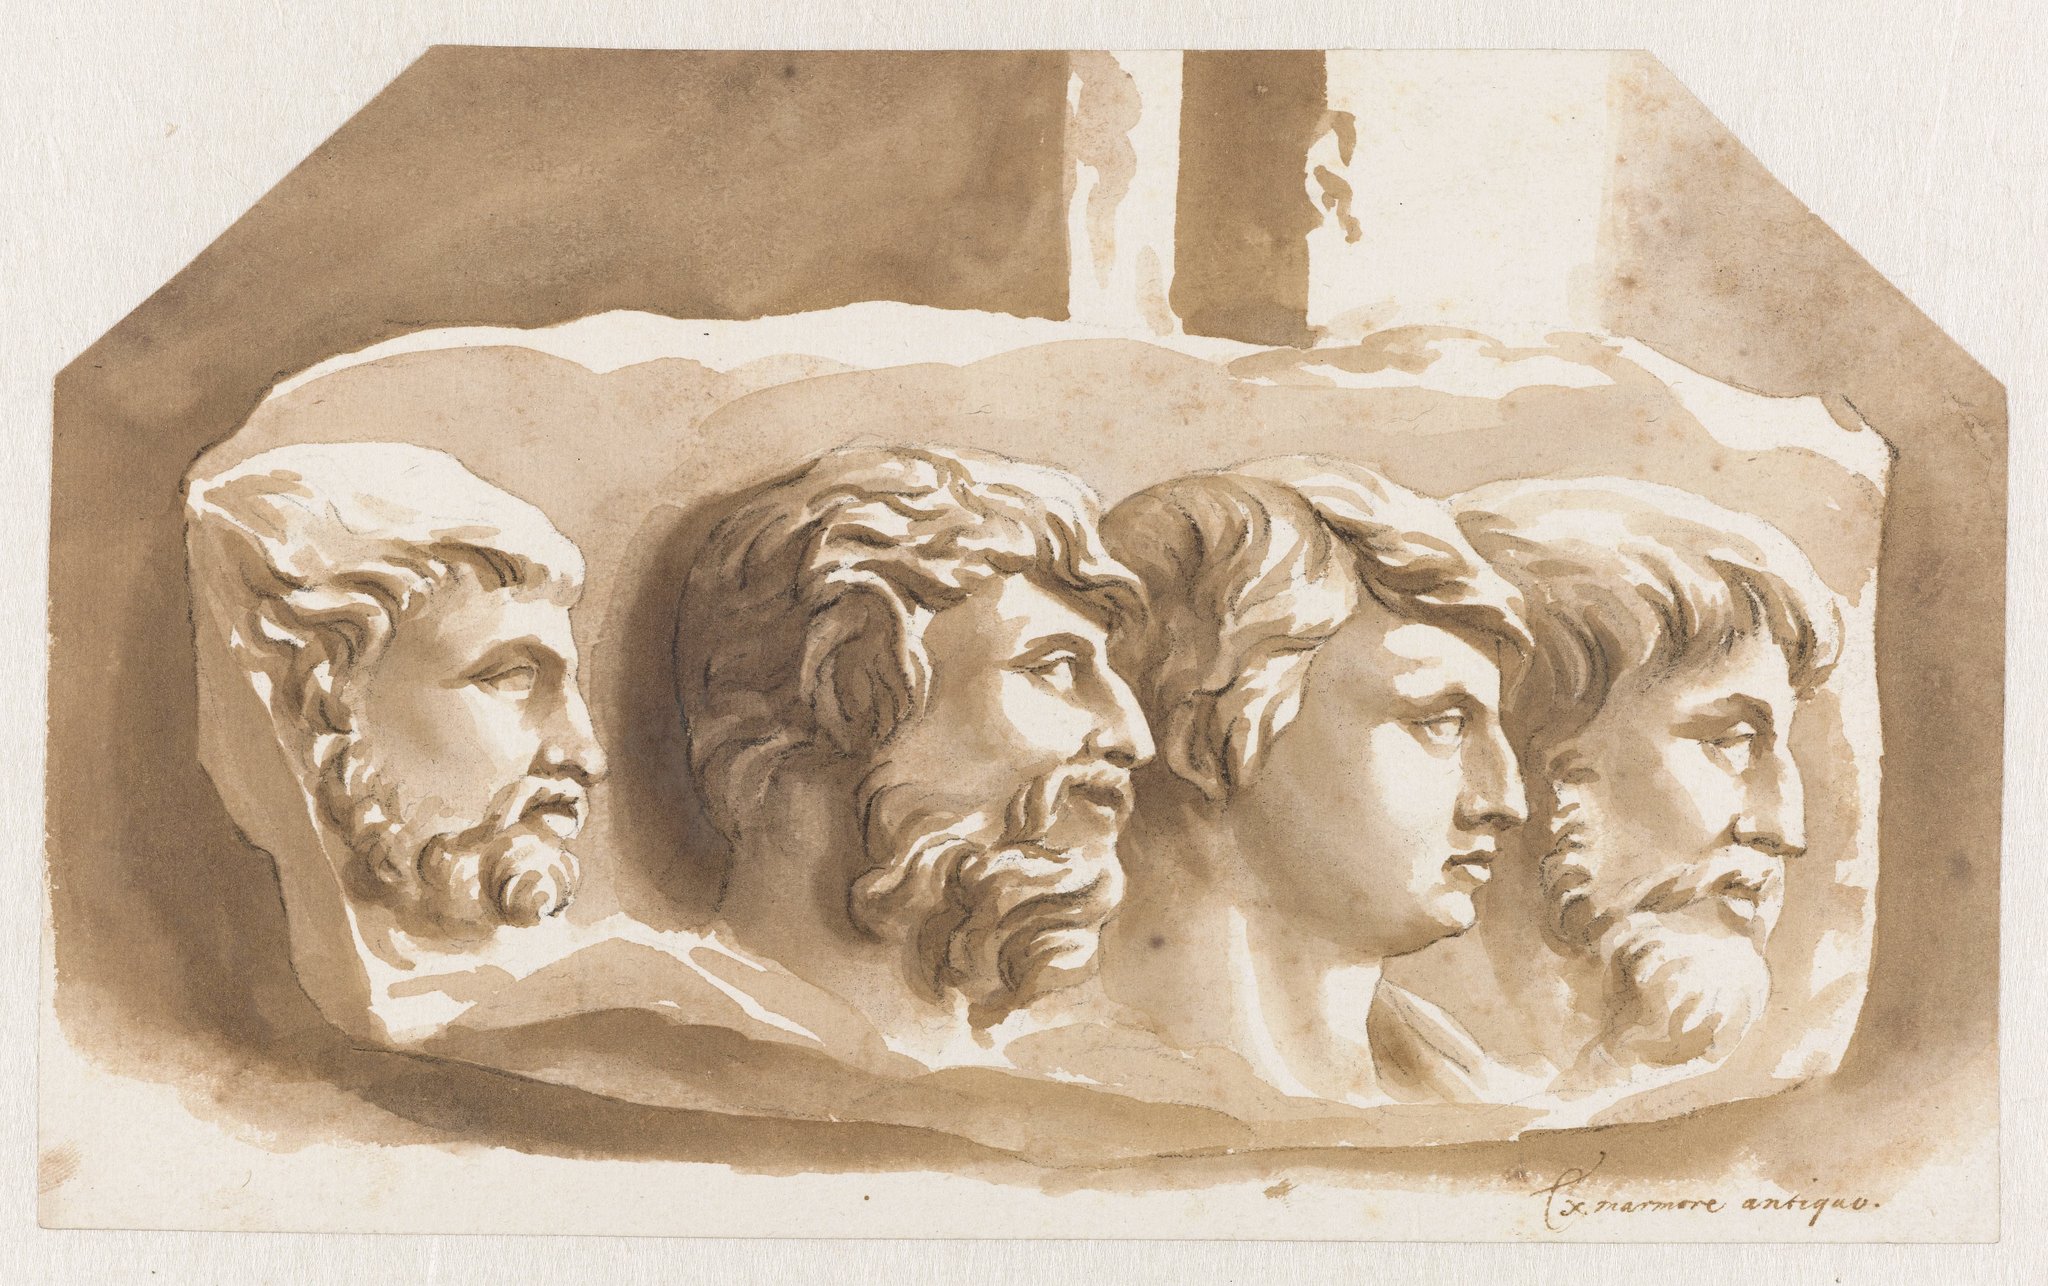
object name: drawing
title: Vier hoofden van mannen, naar rechts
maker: jan de bisschop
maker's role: draughtsman, print maker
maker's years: 1628-1671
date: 1648-1671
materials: chalk, paper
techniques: brush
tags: head (human), piece of sculpture, reproduction of a piece of sculpture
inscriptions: date: ‘3 F.b. 1668’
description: Kopie naar reliëf met vier hoofden van mannen.